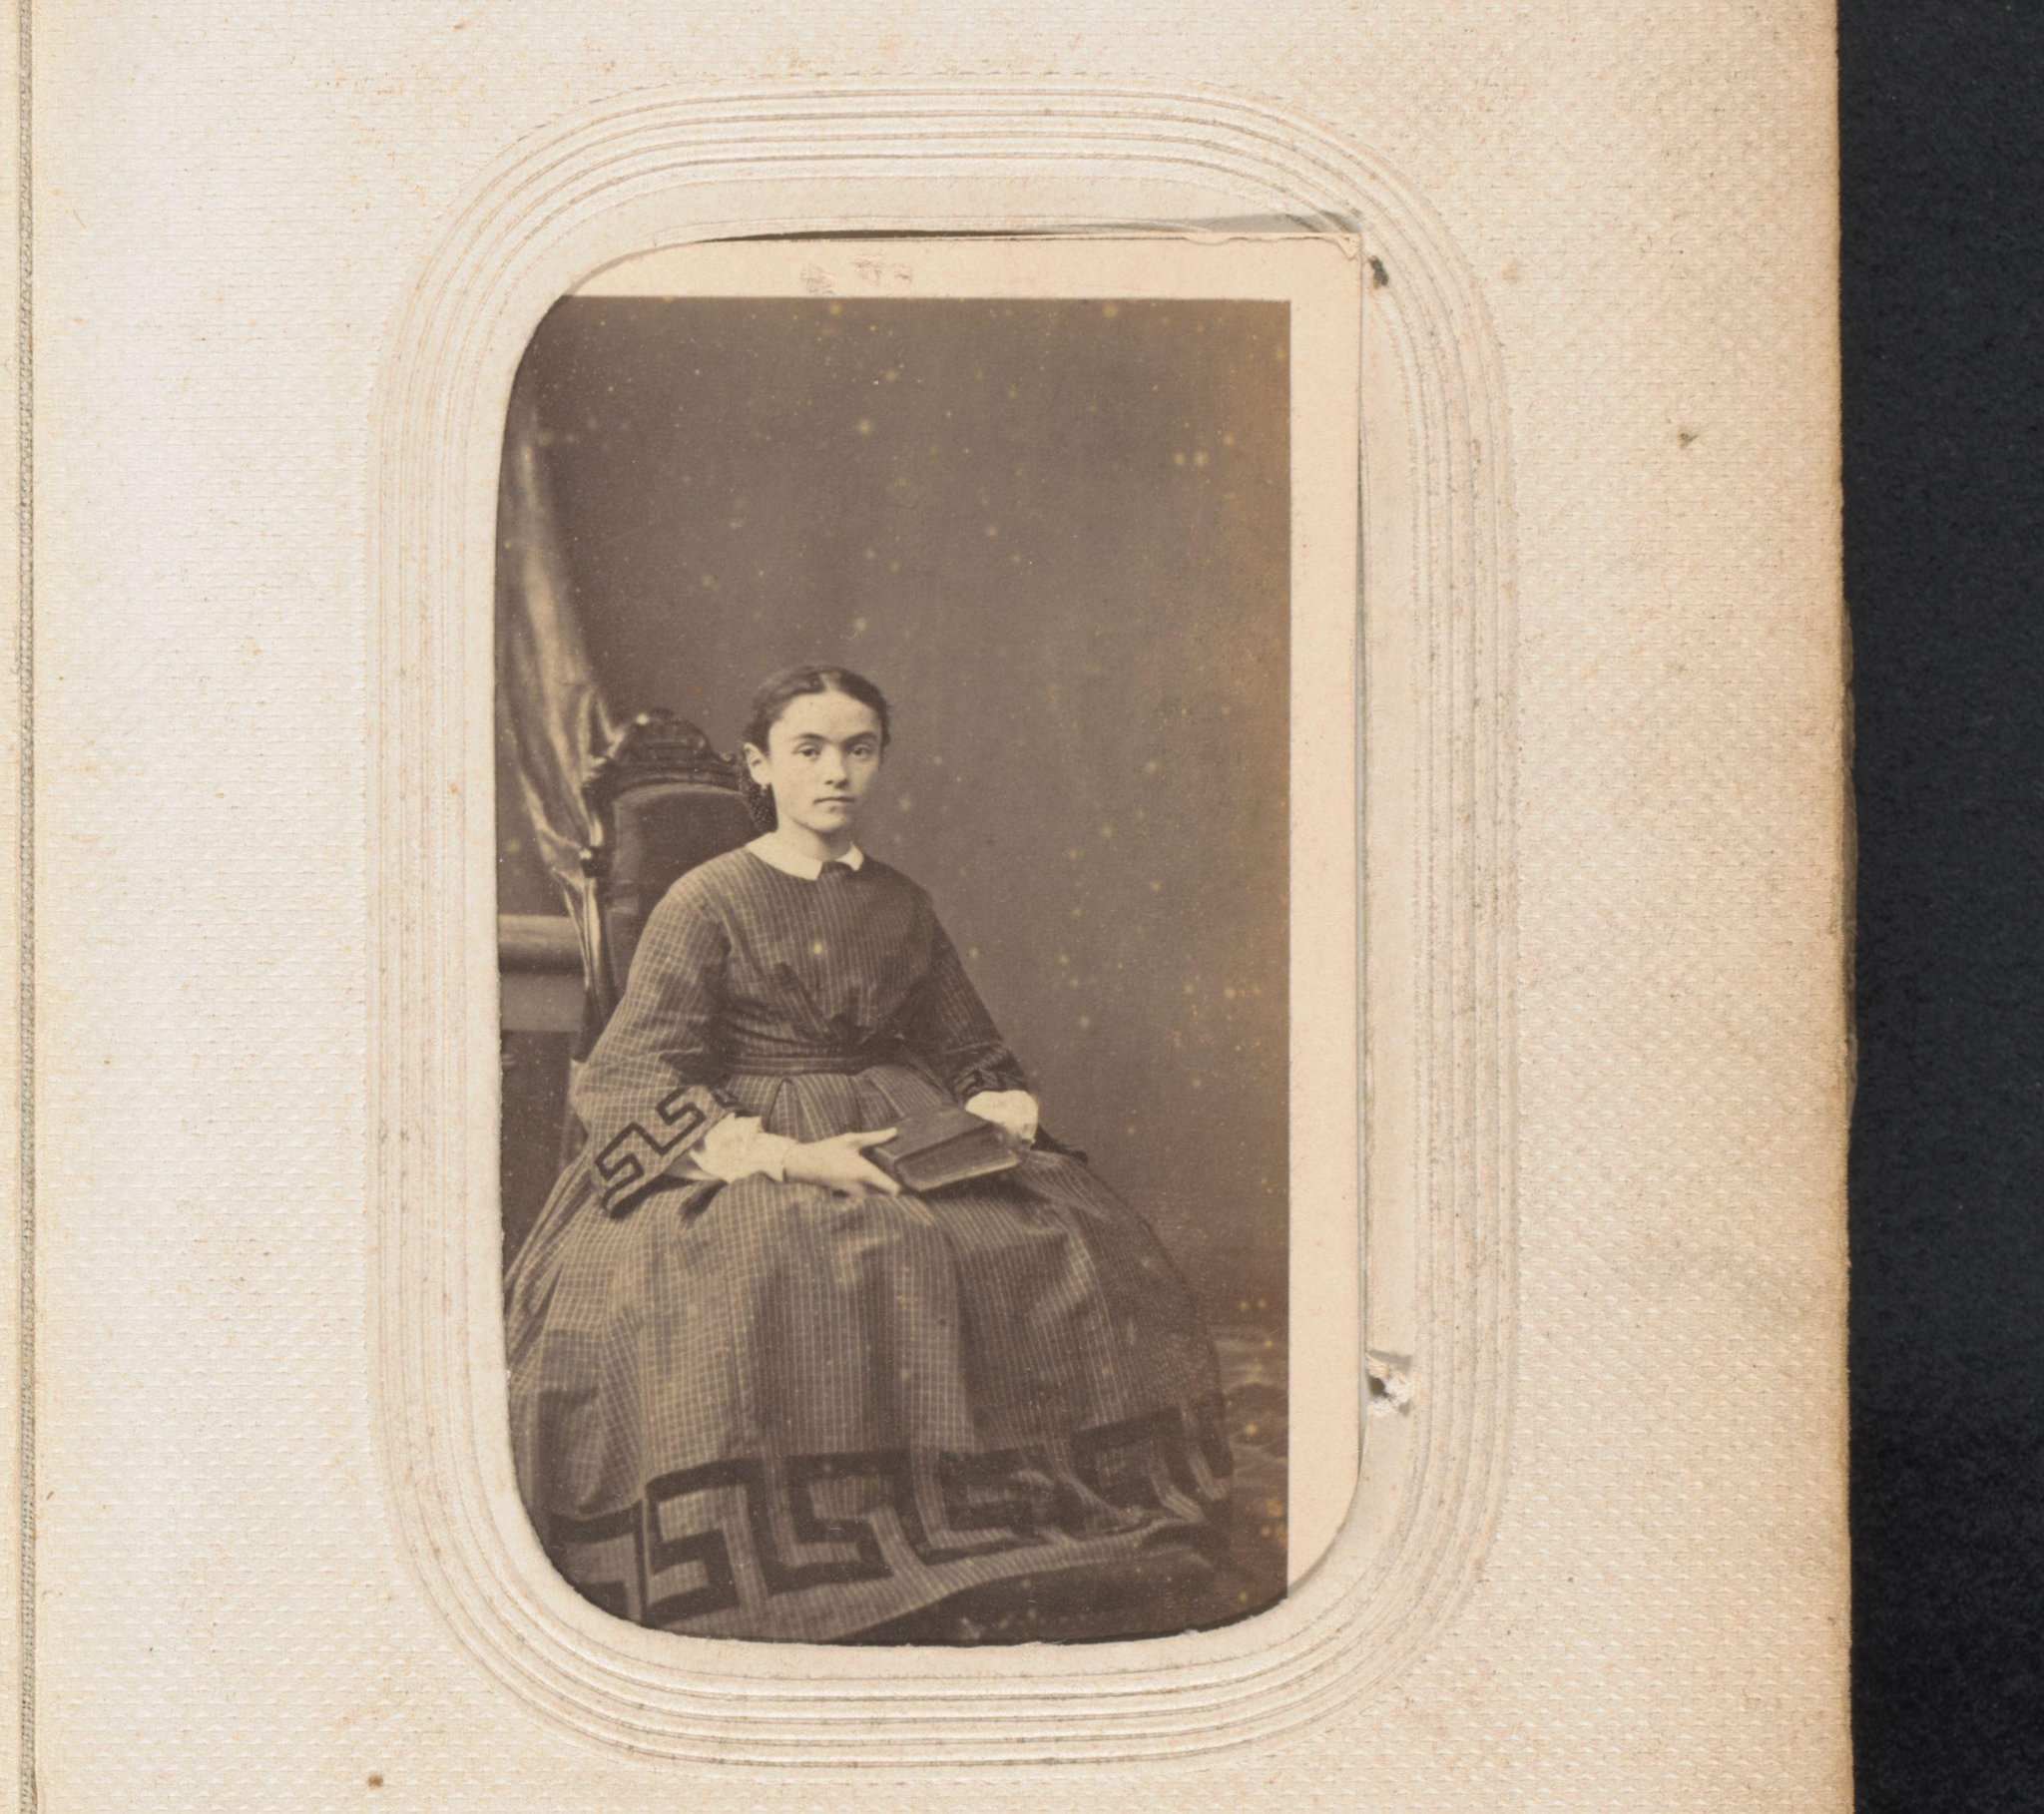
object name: album leaf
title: Portret van een zittend meisje met boek op schoot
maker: pierre julien calixte fourié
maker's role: fotograaf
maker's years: 1832-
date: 1855-1865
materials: cardboard, photographic support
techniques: albumen print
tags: adolescent, young woman, maiden, historical persons, book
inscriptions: inscription: ‘behoeft restauratie 28 Rue Ste Catherine, Bordeaux’